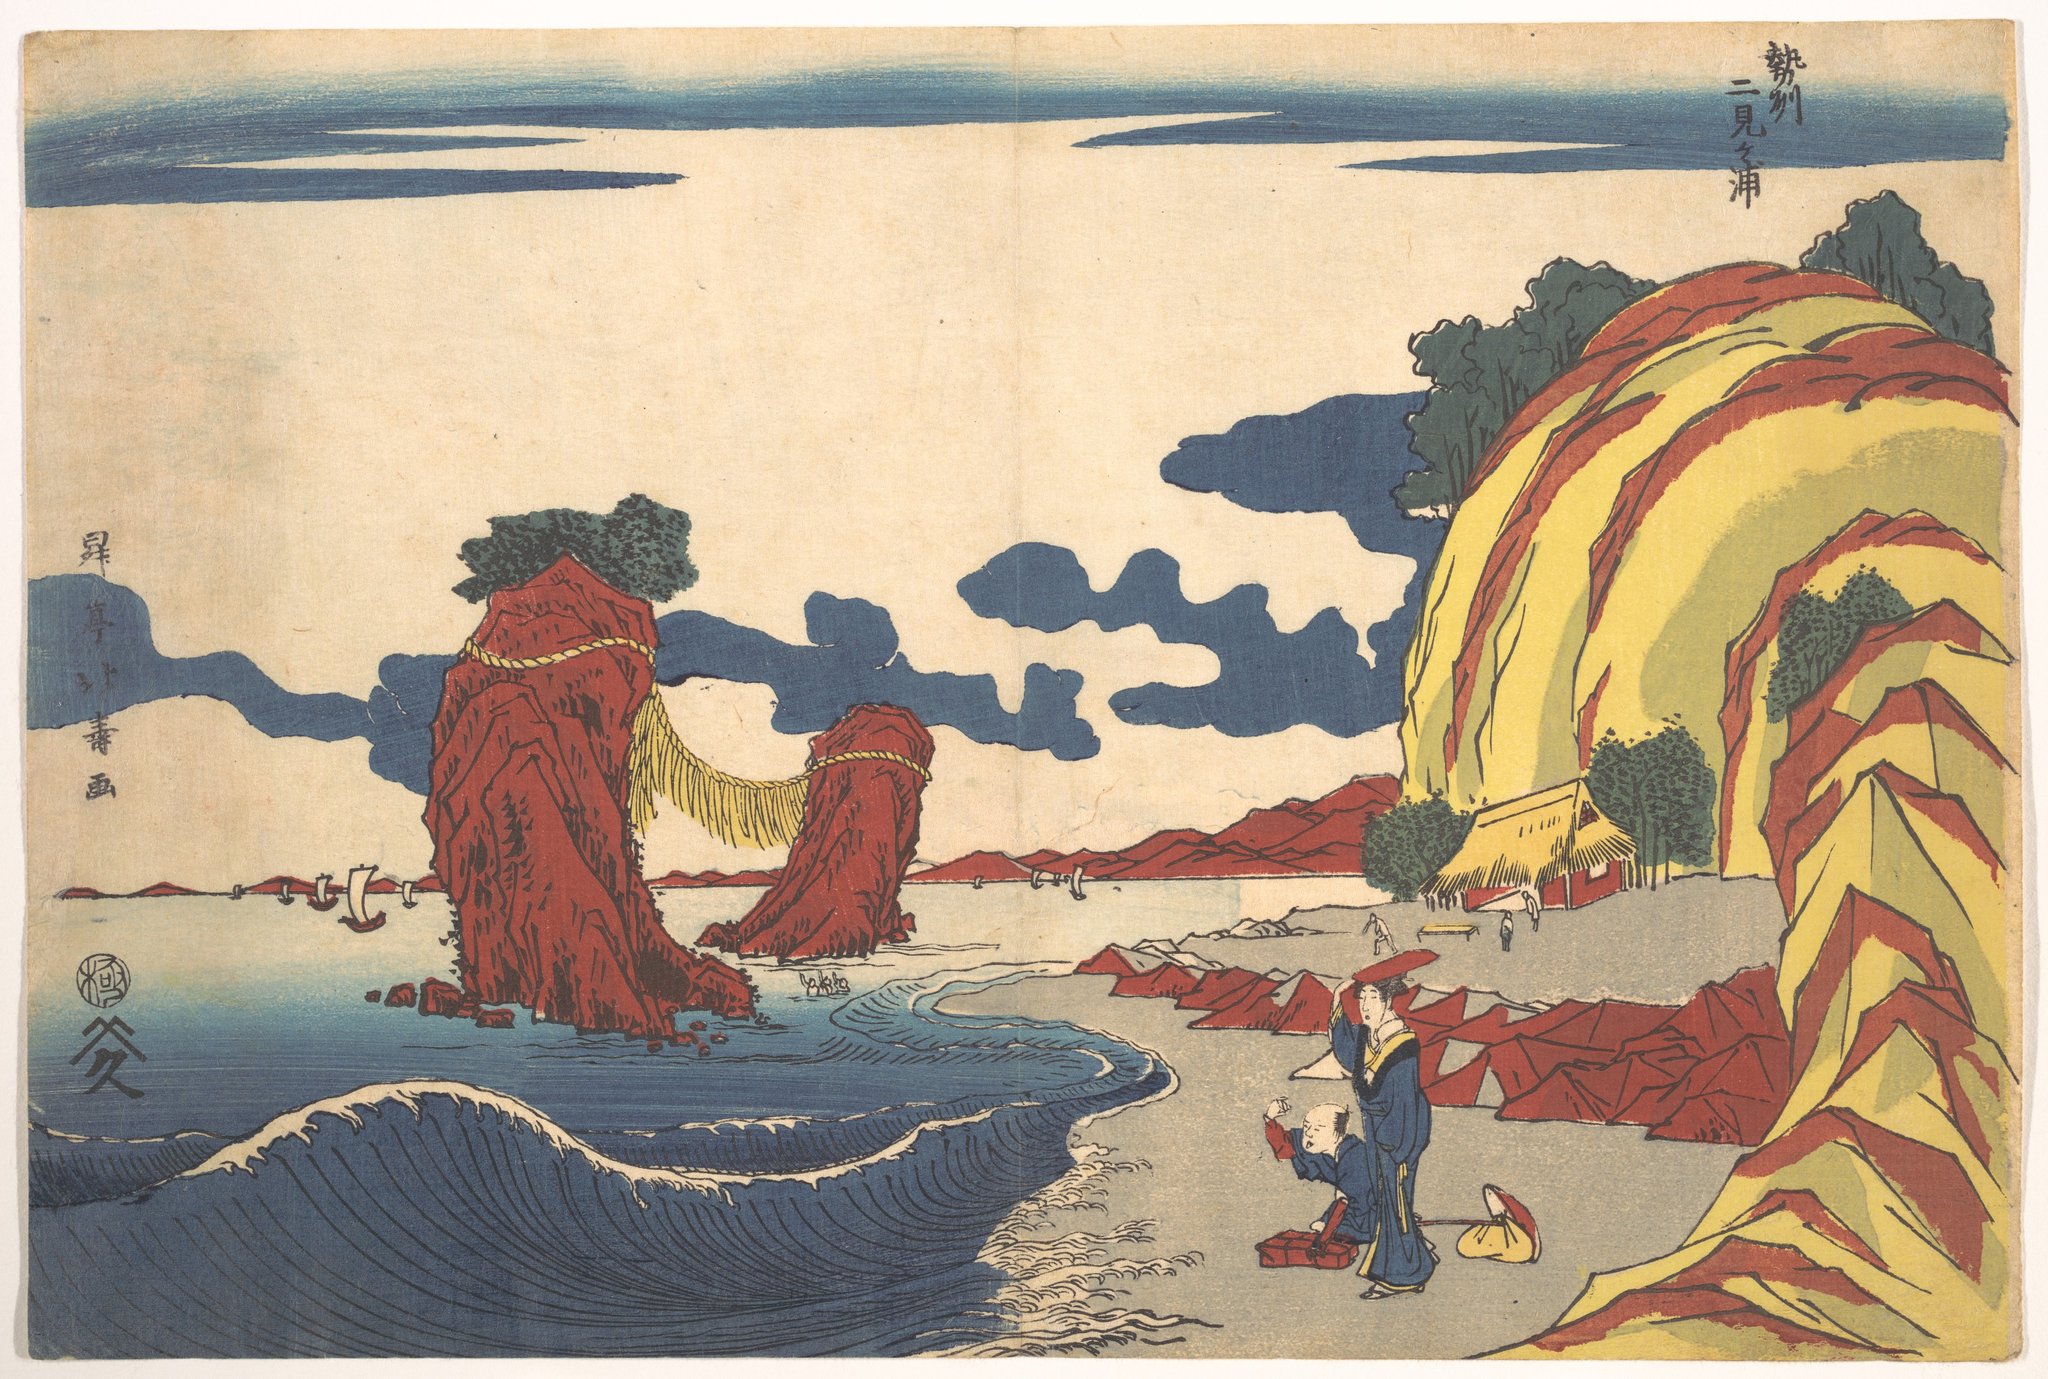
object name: print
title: View of Futami Beach at Ise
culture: japanese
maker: shōtei hokuju 昇亭北寿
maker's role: artist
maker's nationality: japanese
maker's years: 1790-1820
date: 1810-1820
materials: ink, paper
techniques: woodblock print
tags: beaches,seascapes,waves